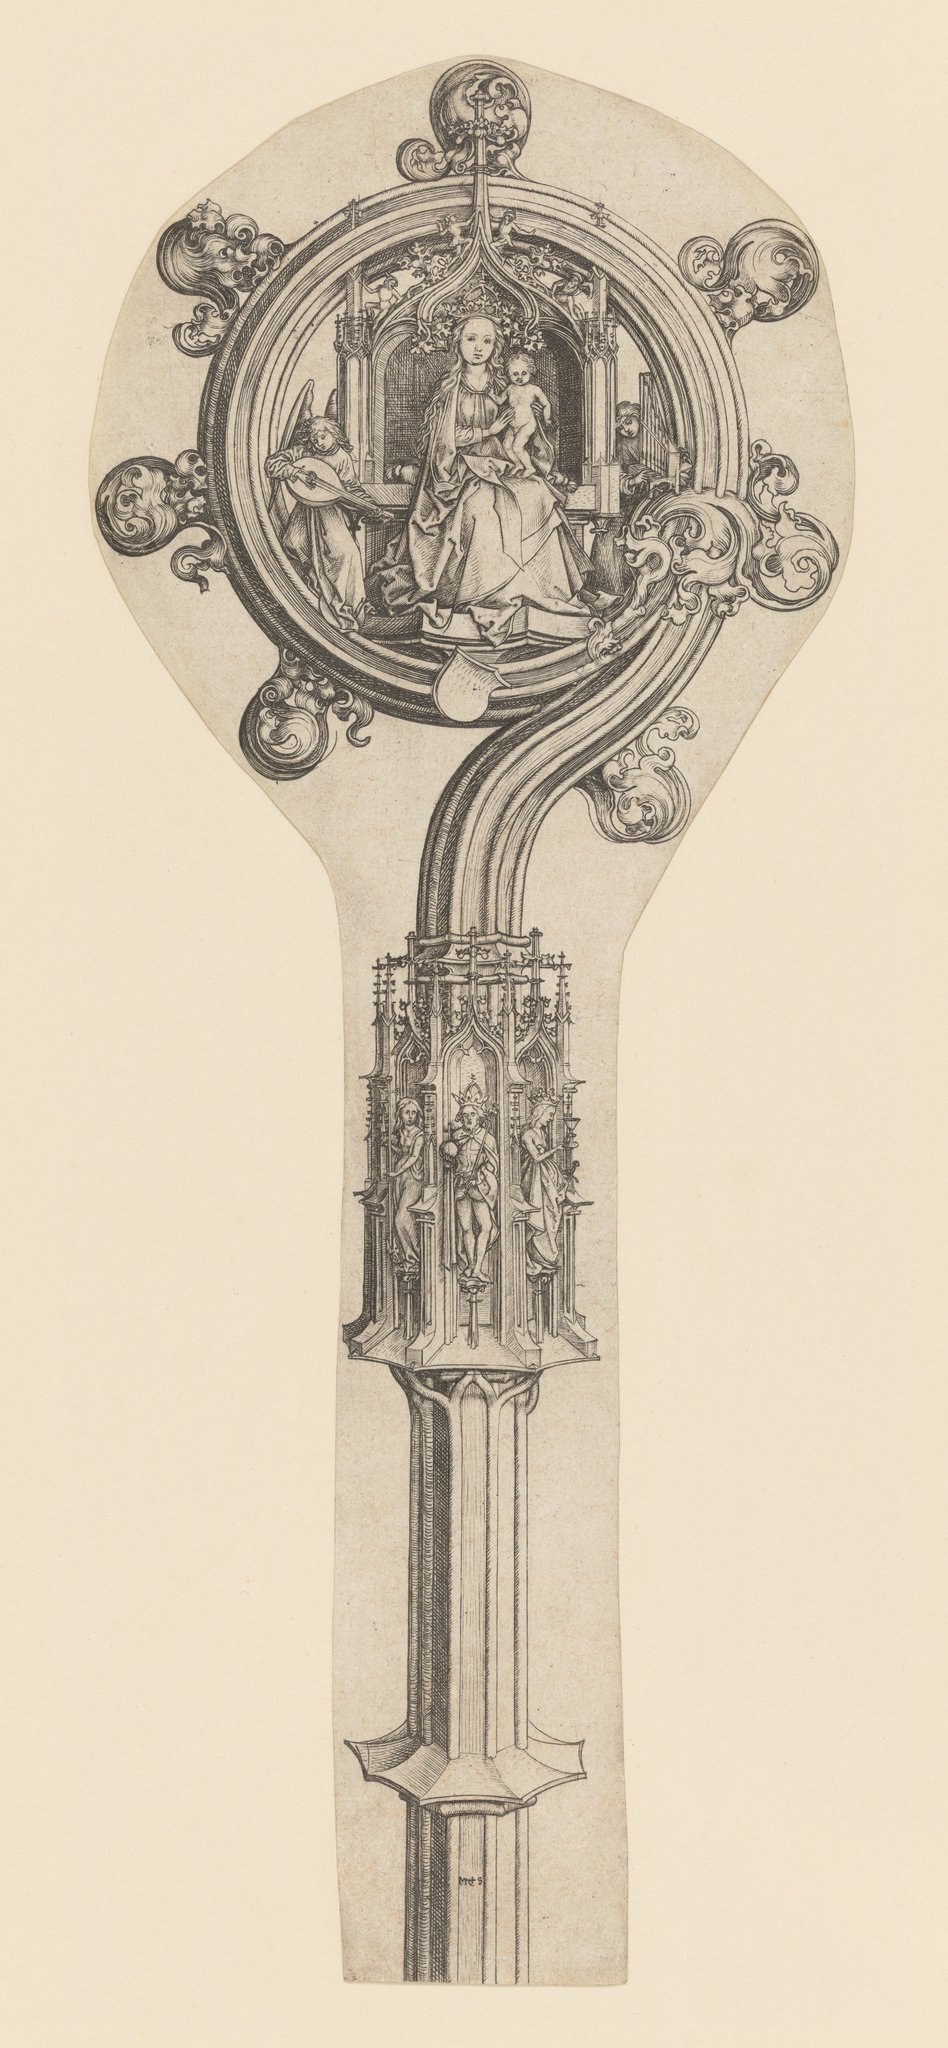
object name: collection ornament architecture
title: The Crozier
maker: martin schongauer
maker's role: artist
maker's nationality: german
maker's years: 1430-1491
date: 1470-1491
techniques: engraving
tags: madonna and child,croziers